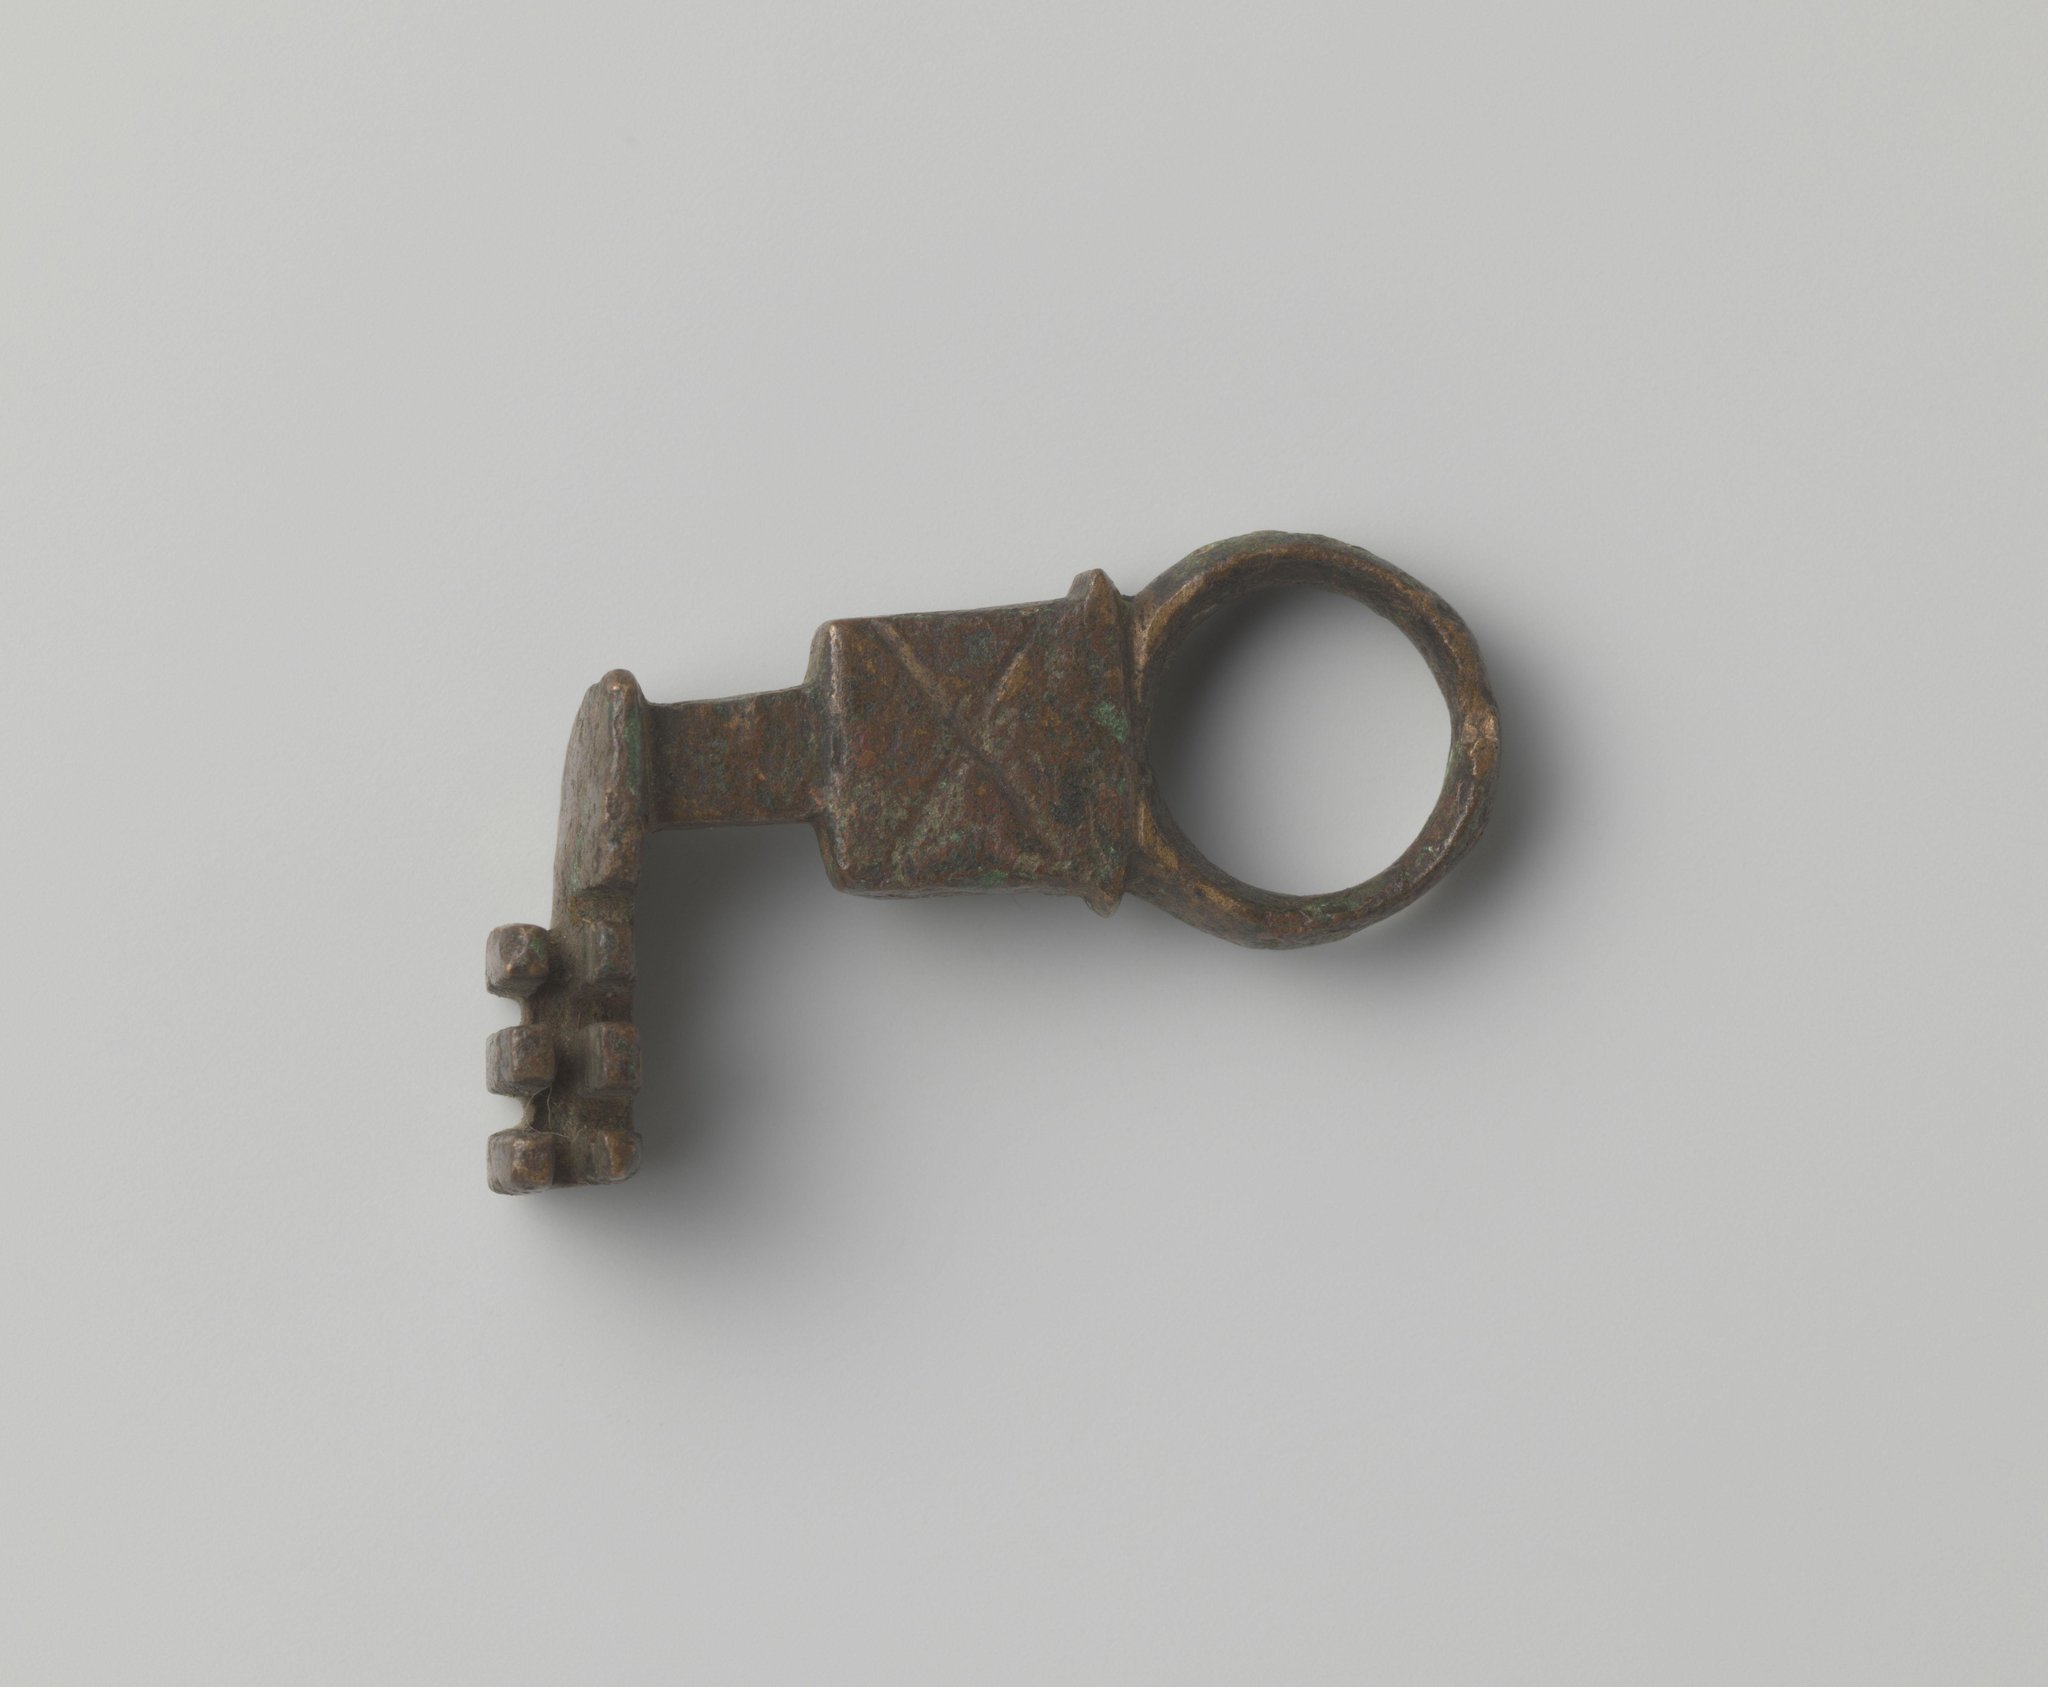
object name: key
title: Sleutel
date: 300-400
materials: bronze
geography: france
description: Bronzen sleutel. Ring rond , daaronder een vierkant steunstuk, waarop een Andreaskruis gegraveerd is. Stam vierkant, de baard staat daar van onderen dwars tegenaan en is zijdelings zesvoudig getand.